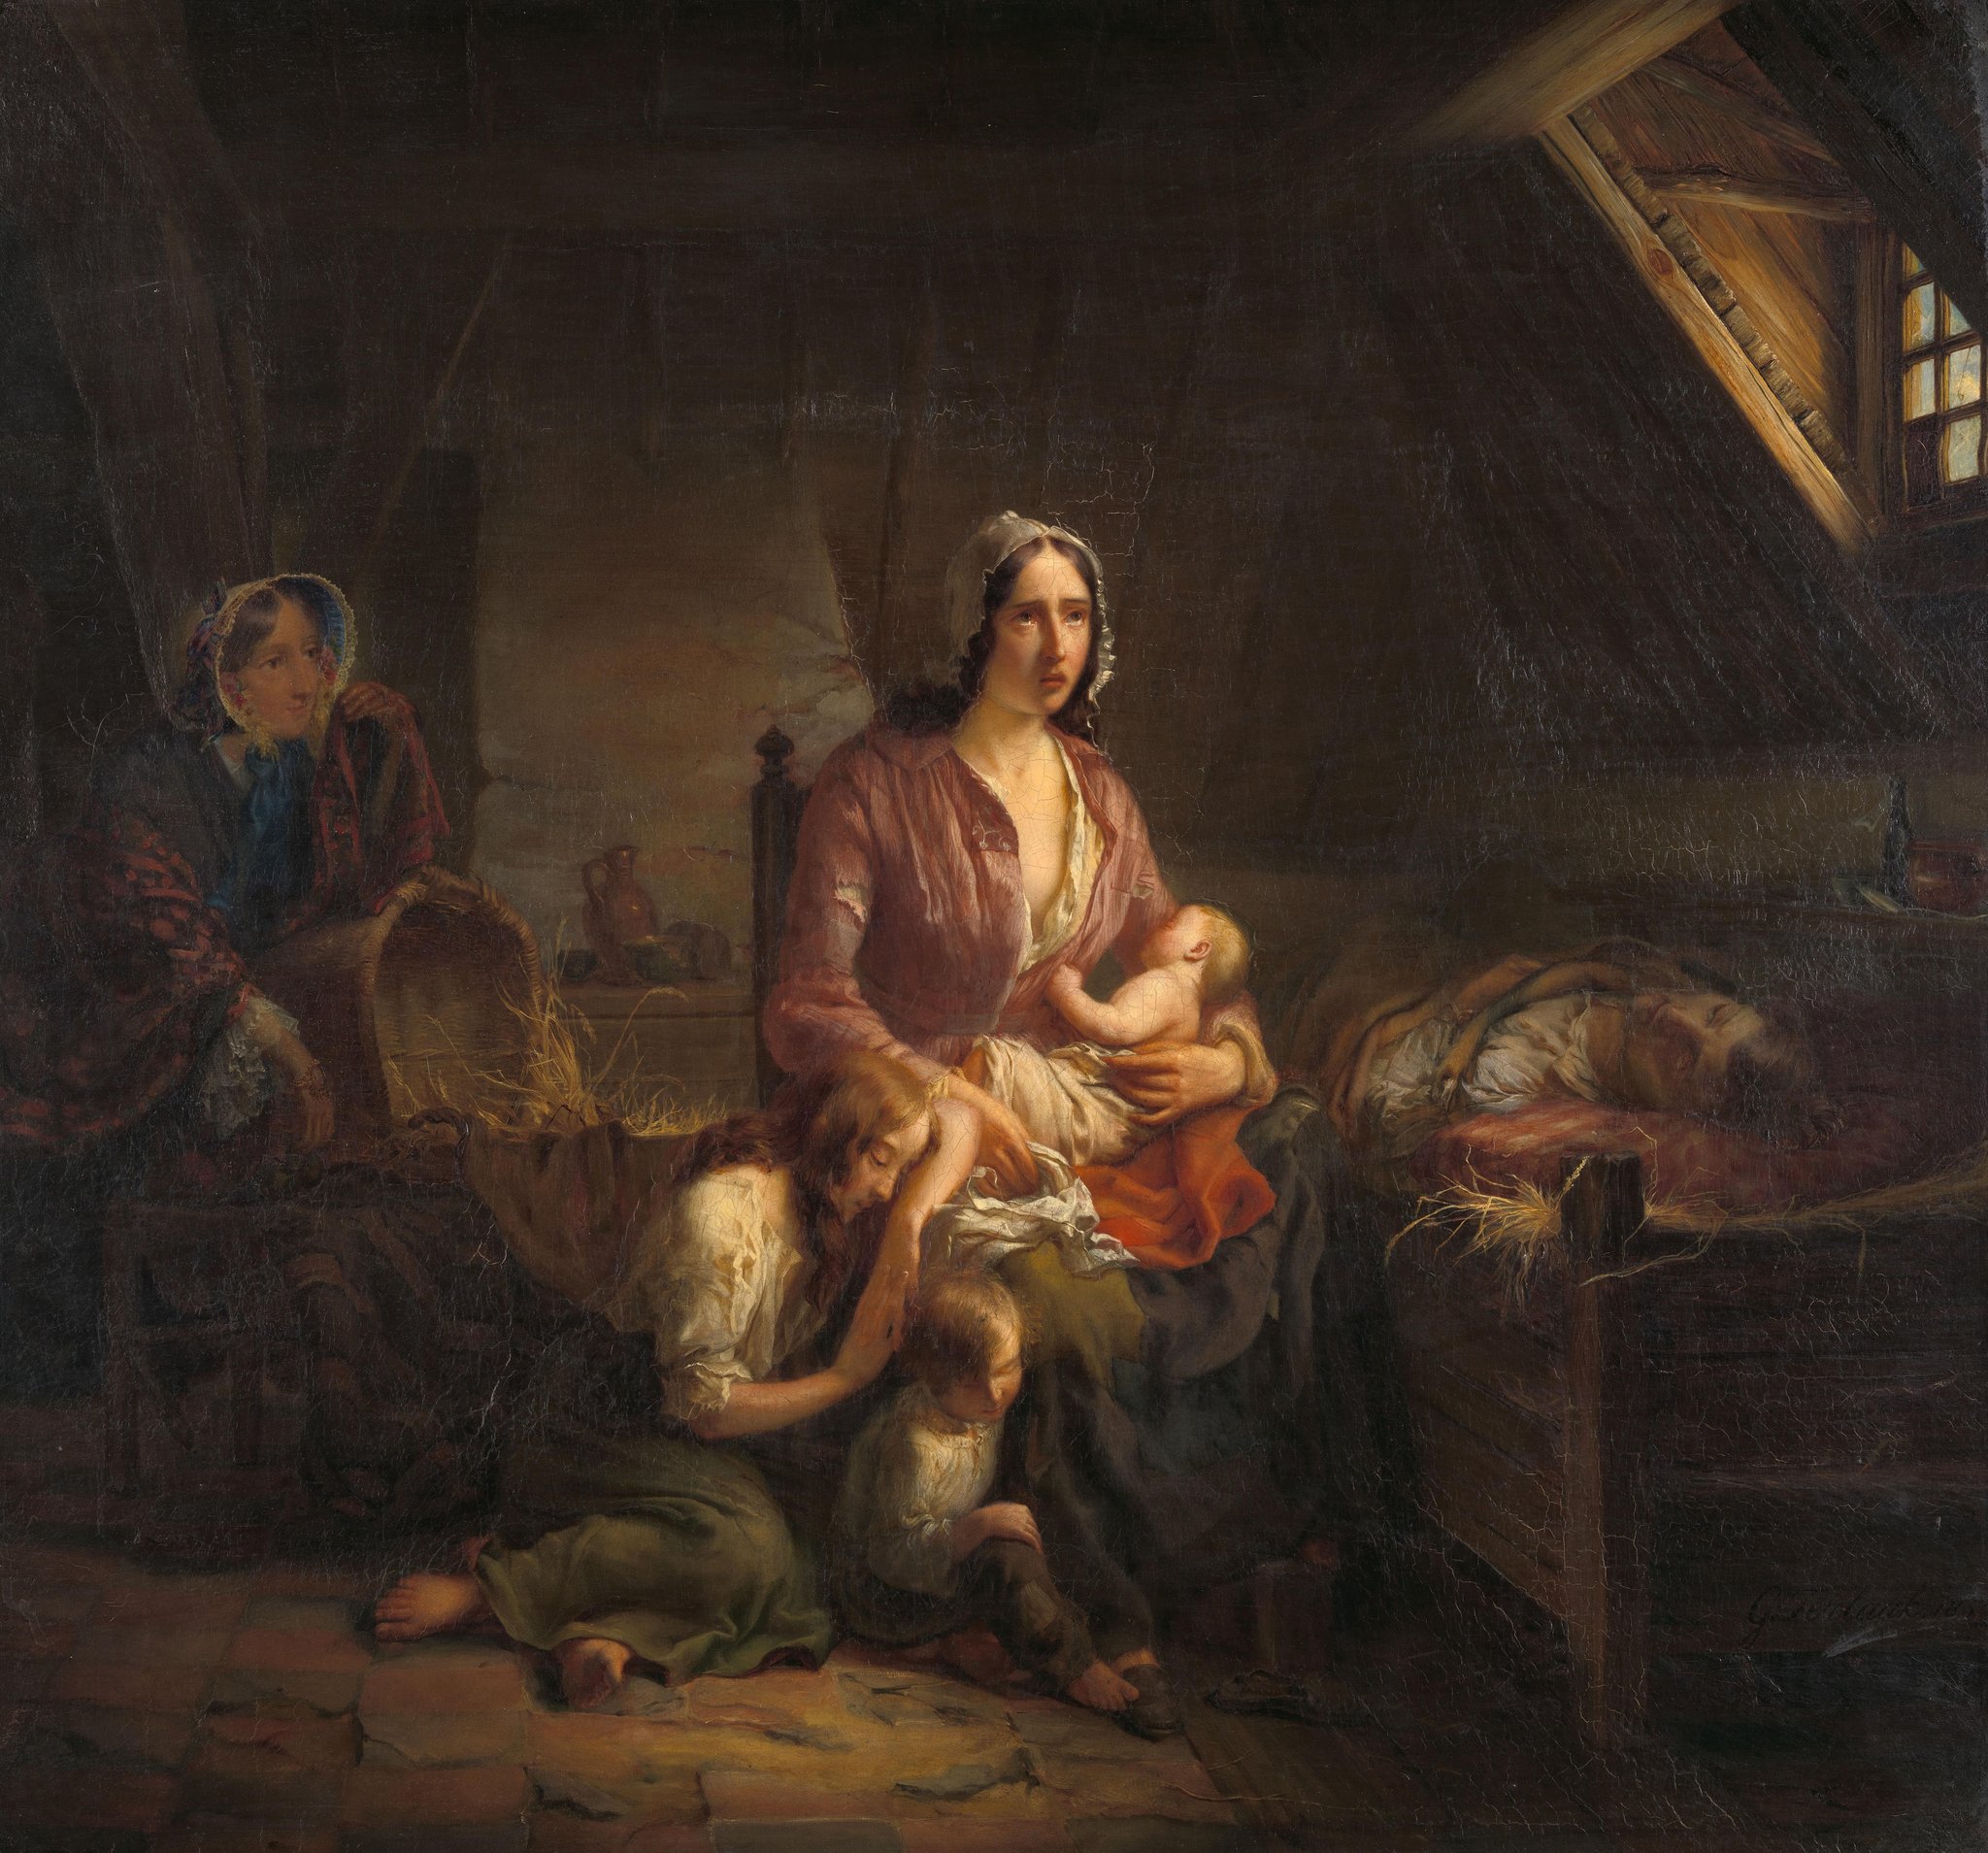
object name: painting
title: A Rich Lady Visits a Poor Family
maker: gerardus terlaak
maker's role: painter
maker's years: 1820-1865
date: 1853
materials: canvas, oil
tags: family group, especially parents with their child(ren), contrast between rich and poor, family life at home, mother and baby or young child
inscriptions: signature and date: ‘G. Terlaak 1853’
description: Een rijke dame bezoekt een arm huisgezin. Voor het bed van haar zieke man zit een jonge moeder met een kind op schoot en twee kinderen aan haar zijde. De vrouw kijkt omhoog. Achterin de kamer bij de wieg kijkt een jonge welgestelde dame toe.